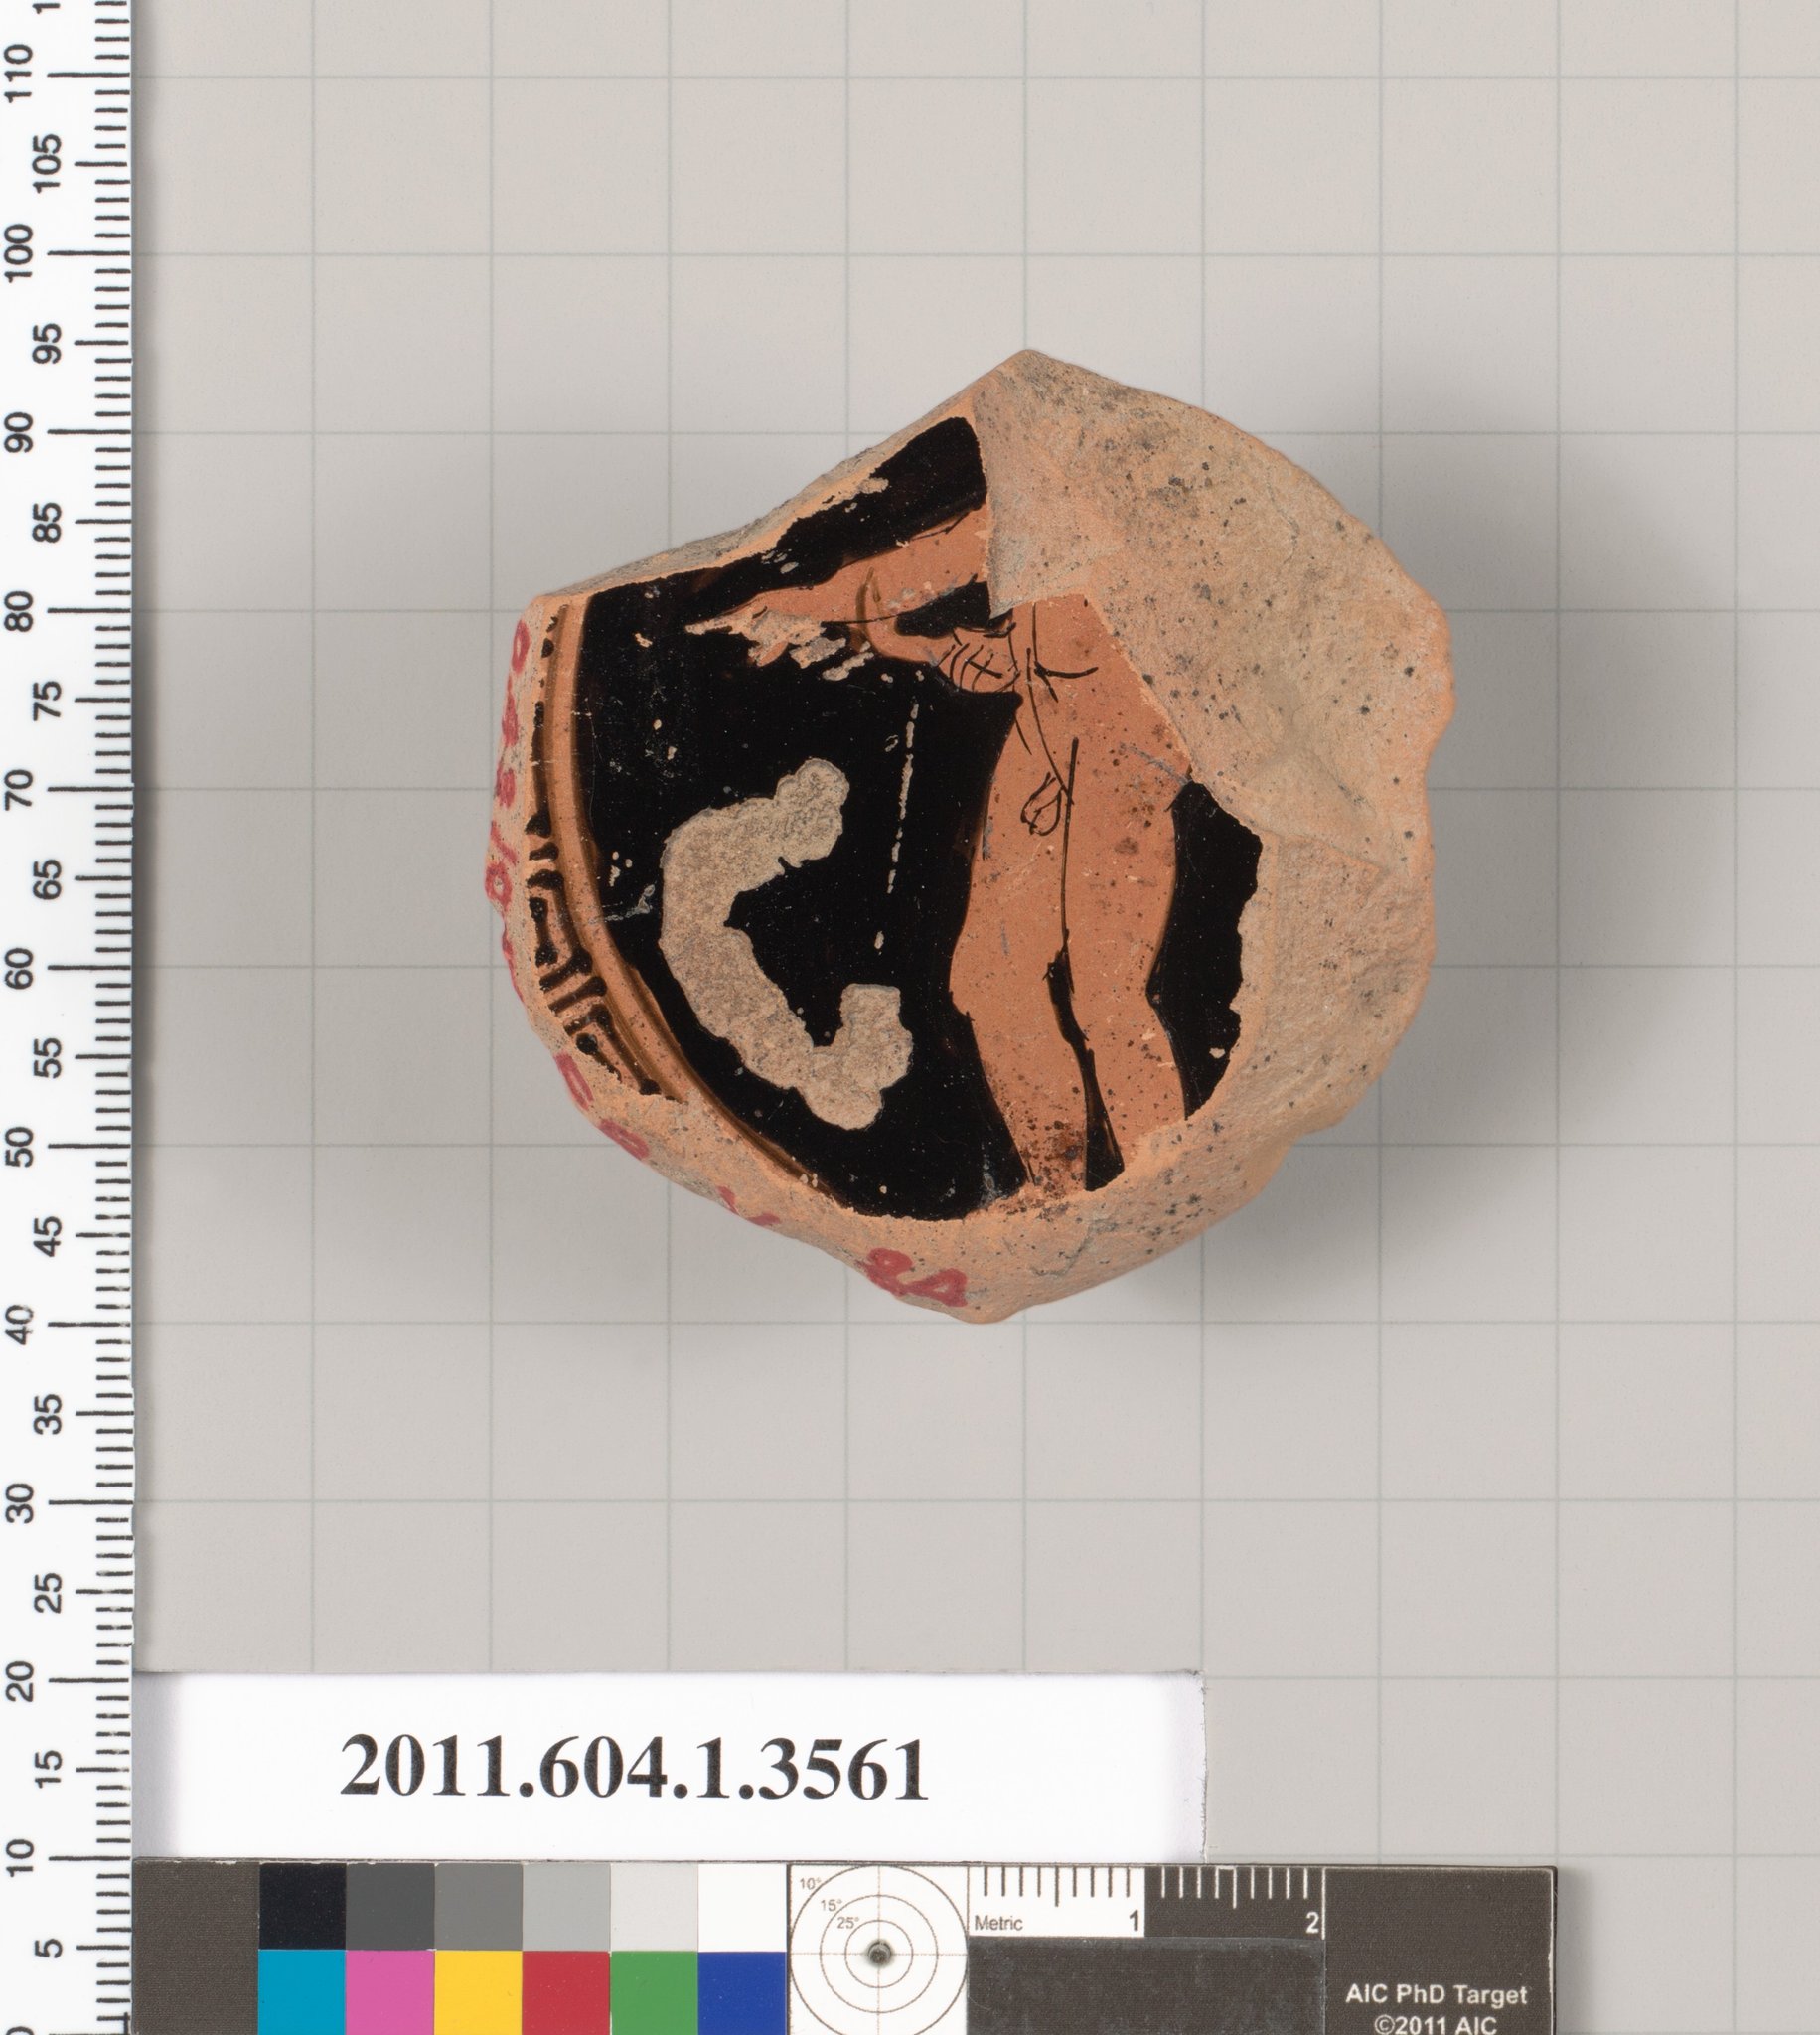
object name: kylix fragment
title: Terracotta fragment of a kylix (drinking cup)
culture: greek, attic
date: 467-435 BCE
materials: terracotta